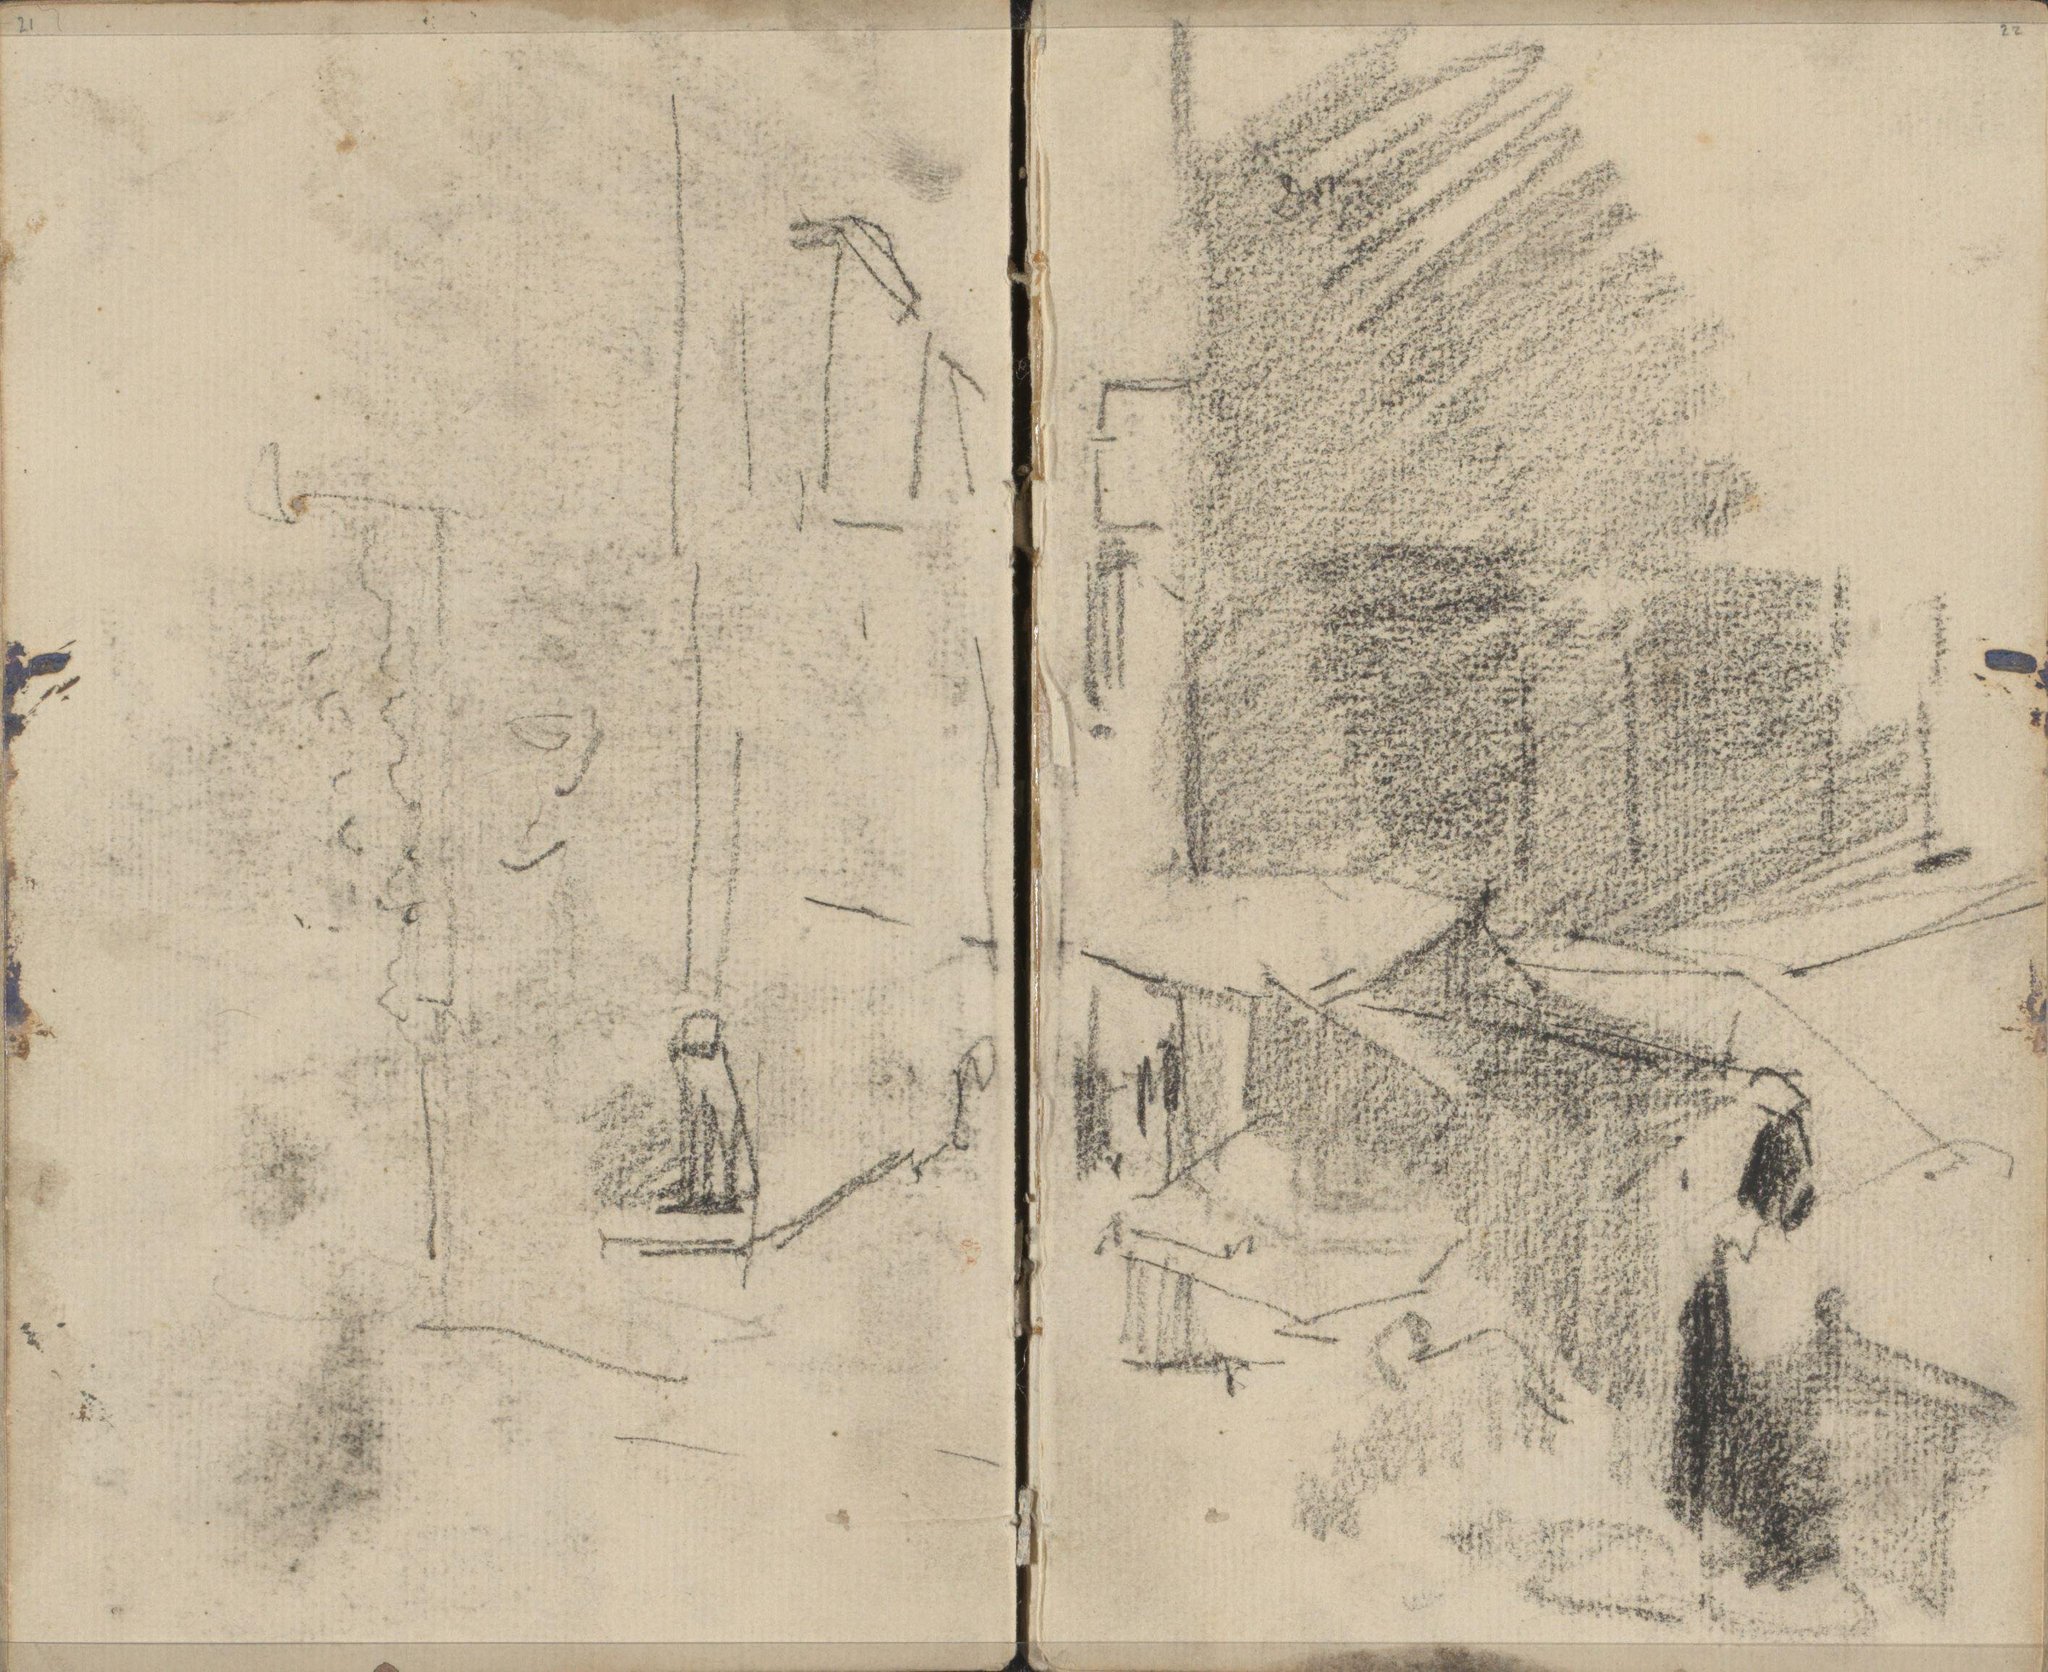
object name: sketchbook leaf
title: Stadsgezicht in Zuid-Holland, mogelijk met een markt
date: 1882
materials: chalk, paper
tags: stall, booth (~ market)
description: Pagina 21 en pagina 22 uit een schetsboek met 31 bladen vervaardigd te Den Haag en Rotterdam.